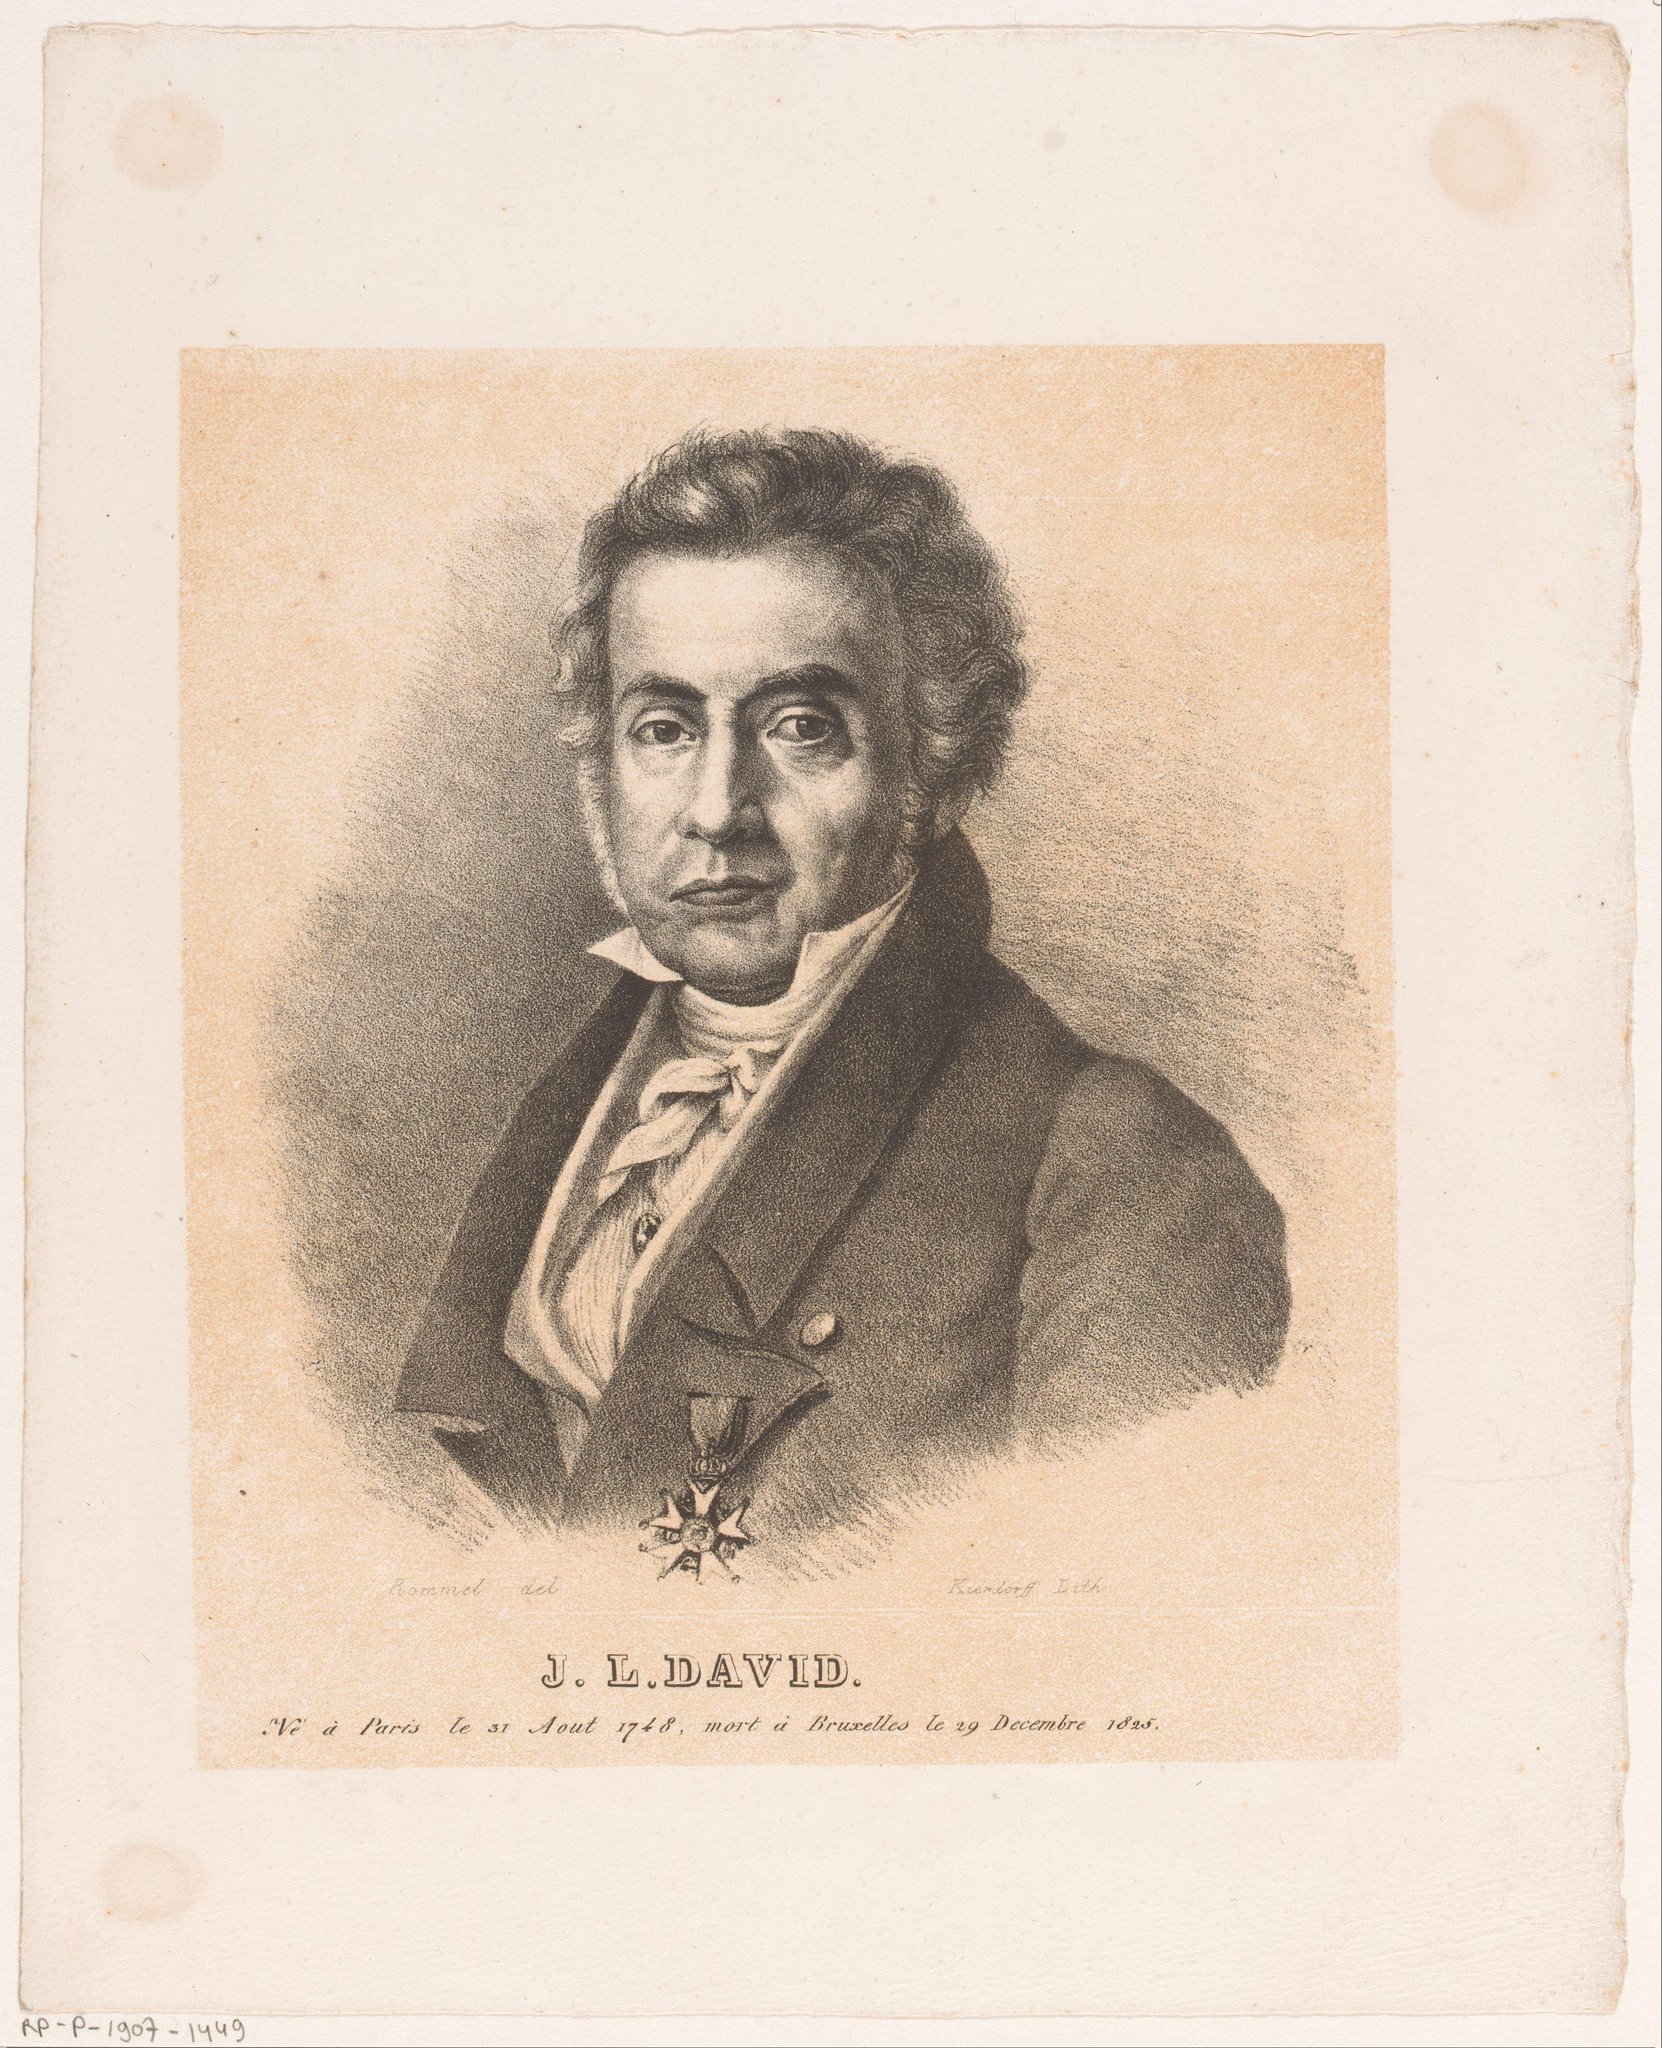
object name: print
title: Portret van Jacques-Louis David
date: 1825-1882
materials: paper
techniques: tone lithography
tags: paris, brussels, painter, draughtsman, jacques-louis david, knighthood order, historical persons (+ (full) bust portrait)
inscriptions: collector's mark: Lugt 2228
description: De geportretteerde draagt een ridderorde op de revers van zijn jas. Onder het portret zijn naam en geboorte- en sterfjaar.